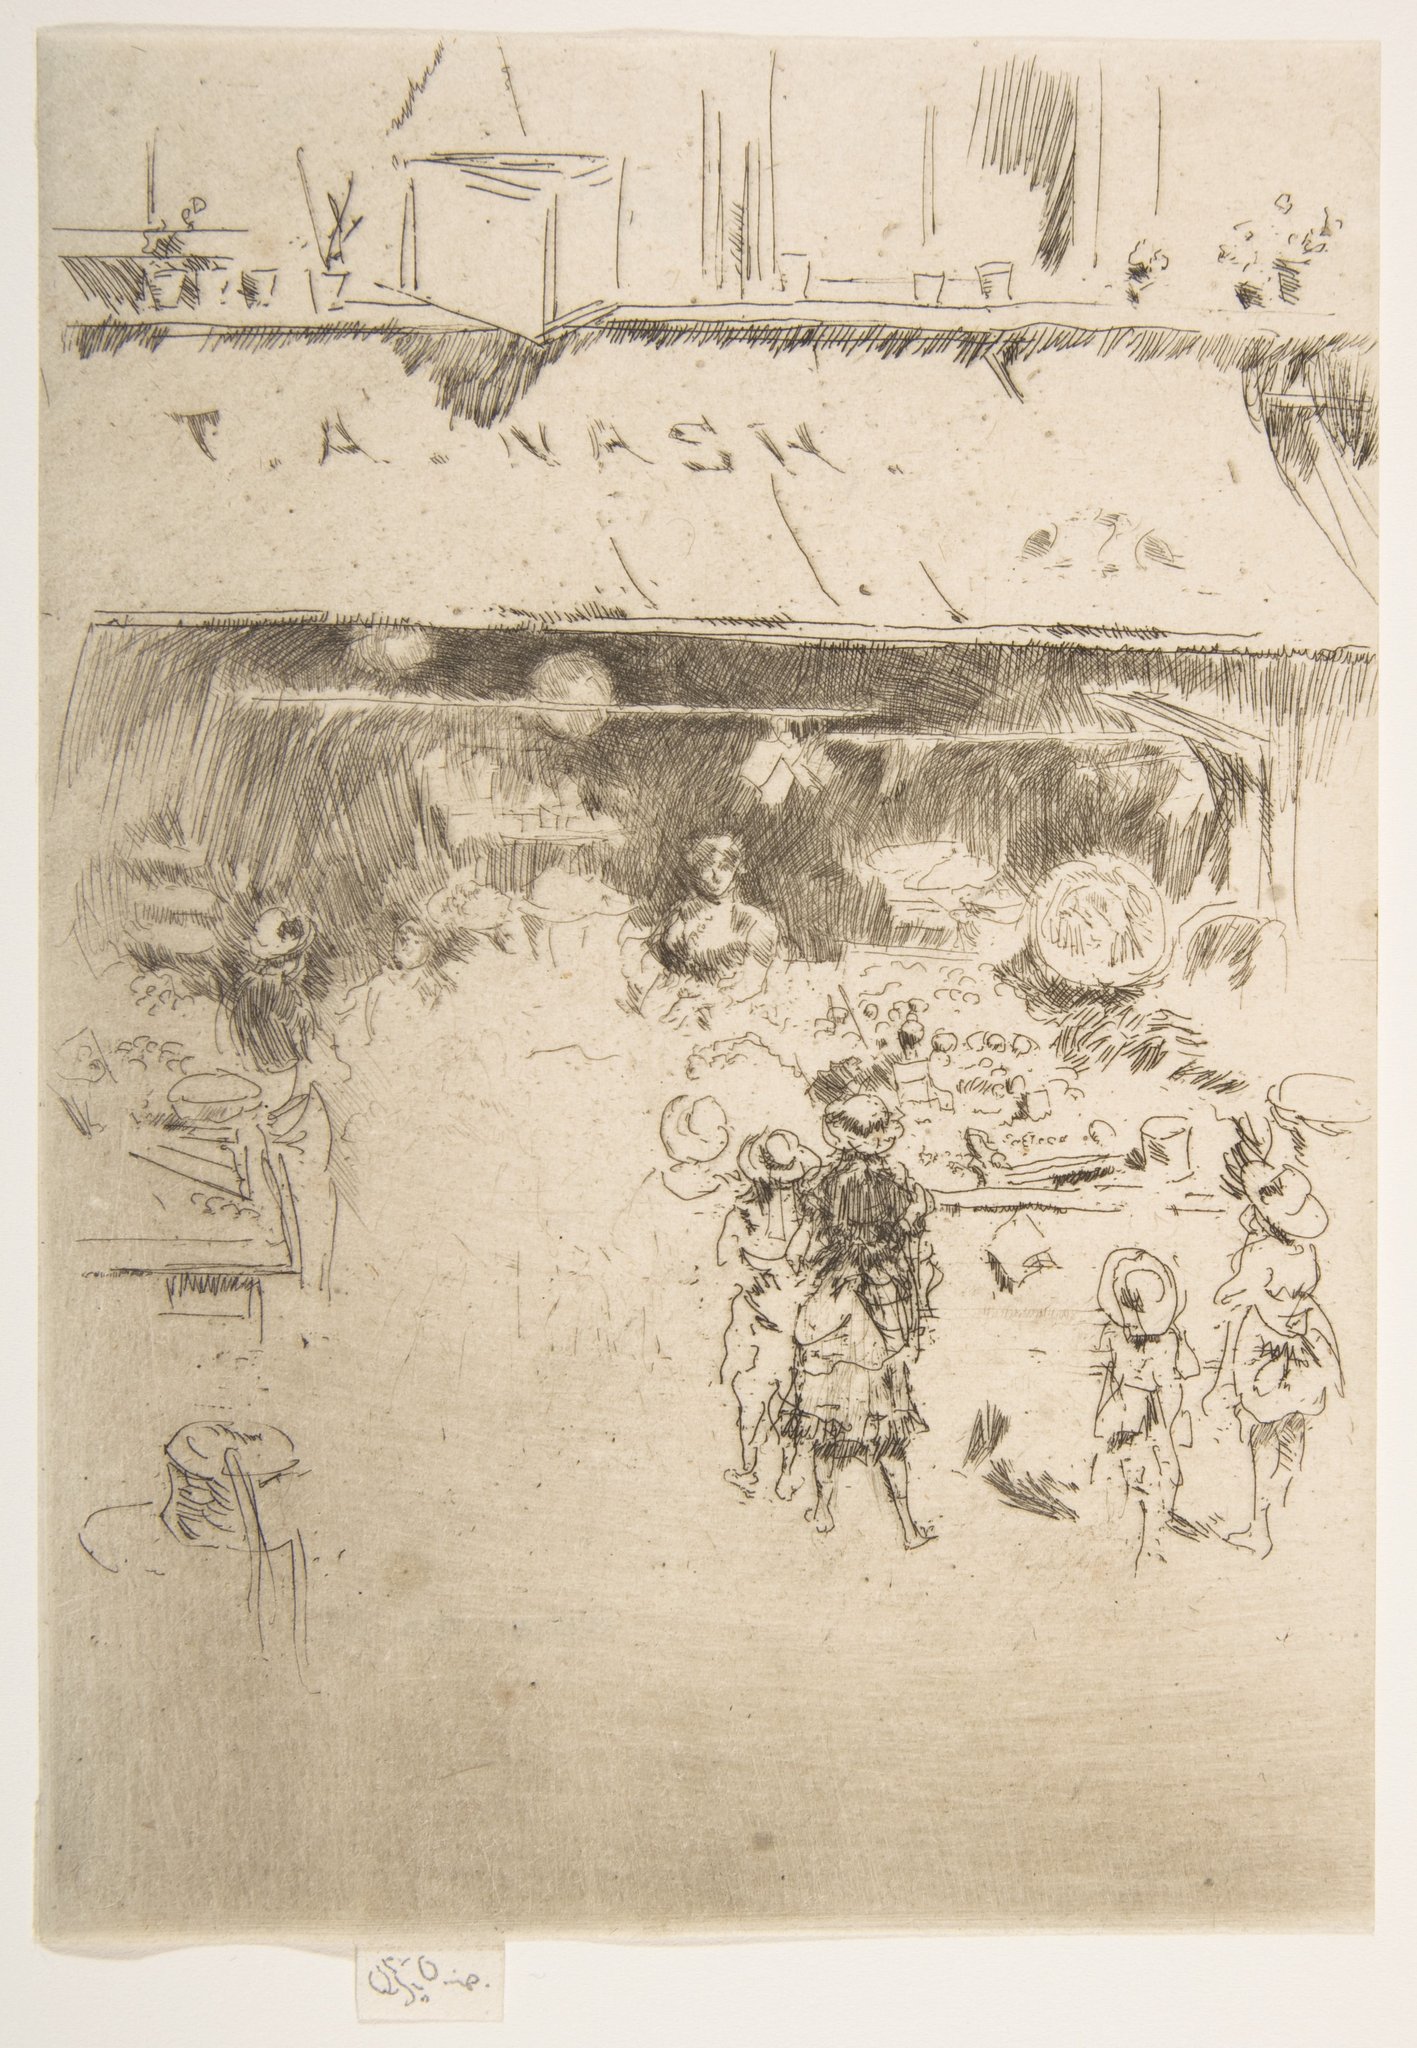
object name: print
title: T. A. Nash's Fruit Shop (T. A. Nash's Greengrocer's Shop)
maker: james mcneill whistler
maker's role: artist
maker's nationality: american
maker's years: 1834-1903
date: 1887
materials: ink, paper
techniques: drypoint, etching, printing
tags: human figures